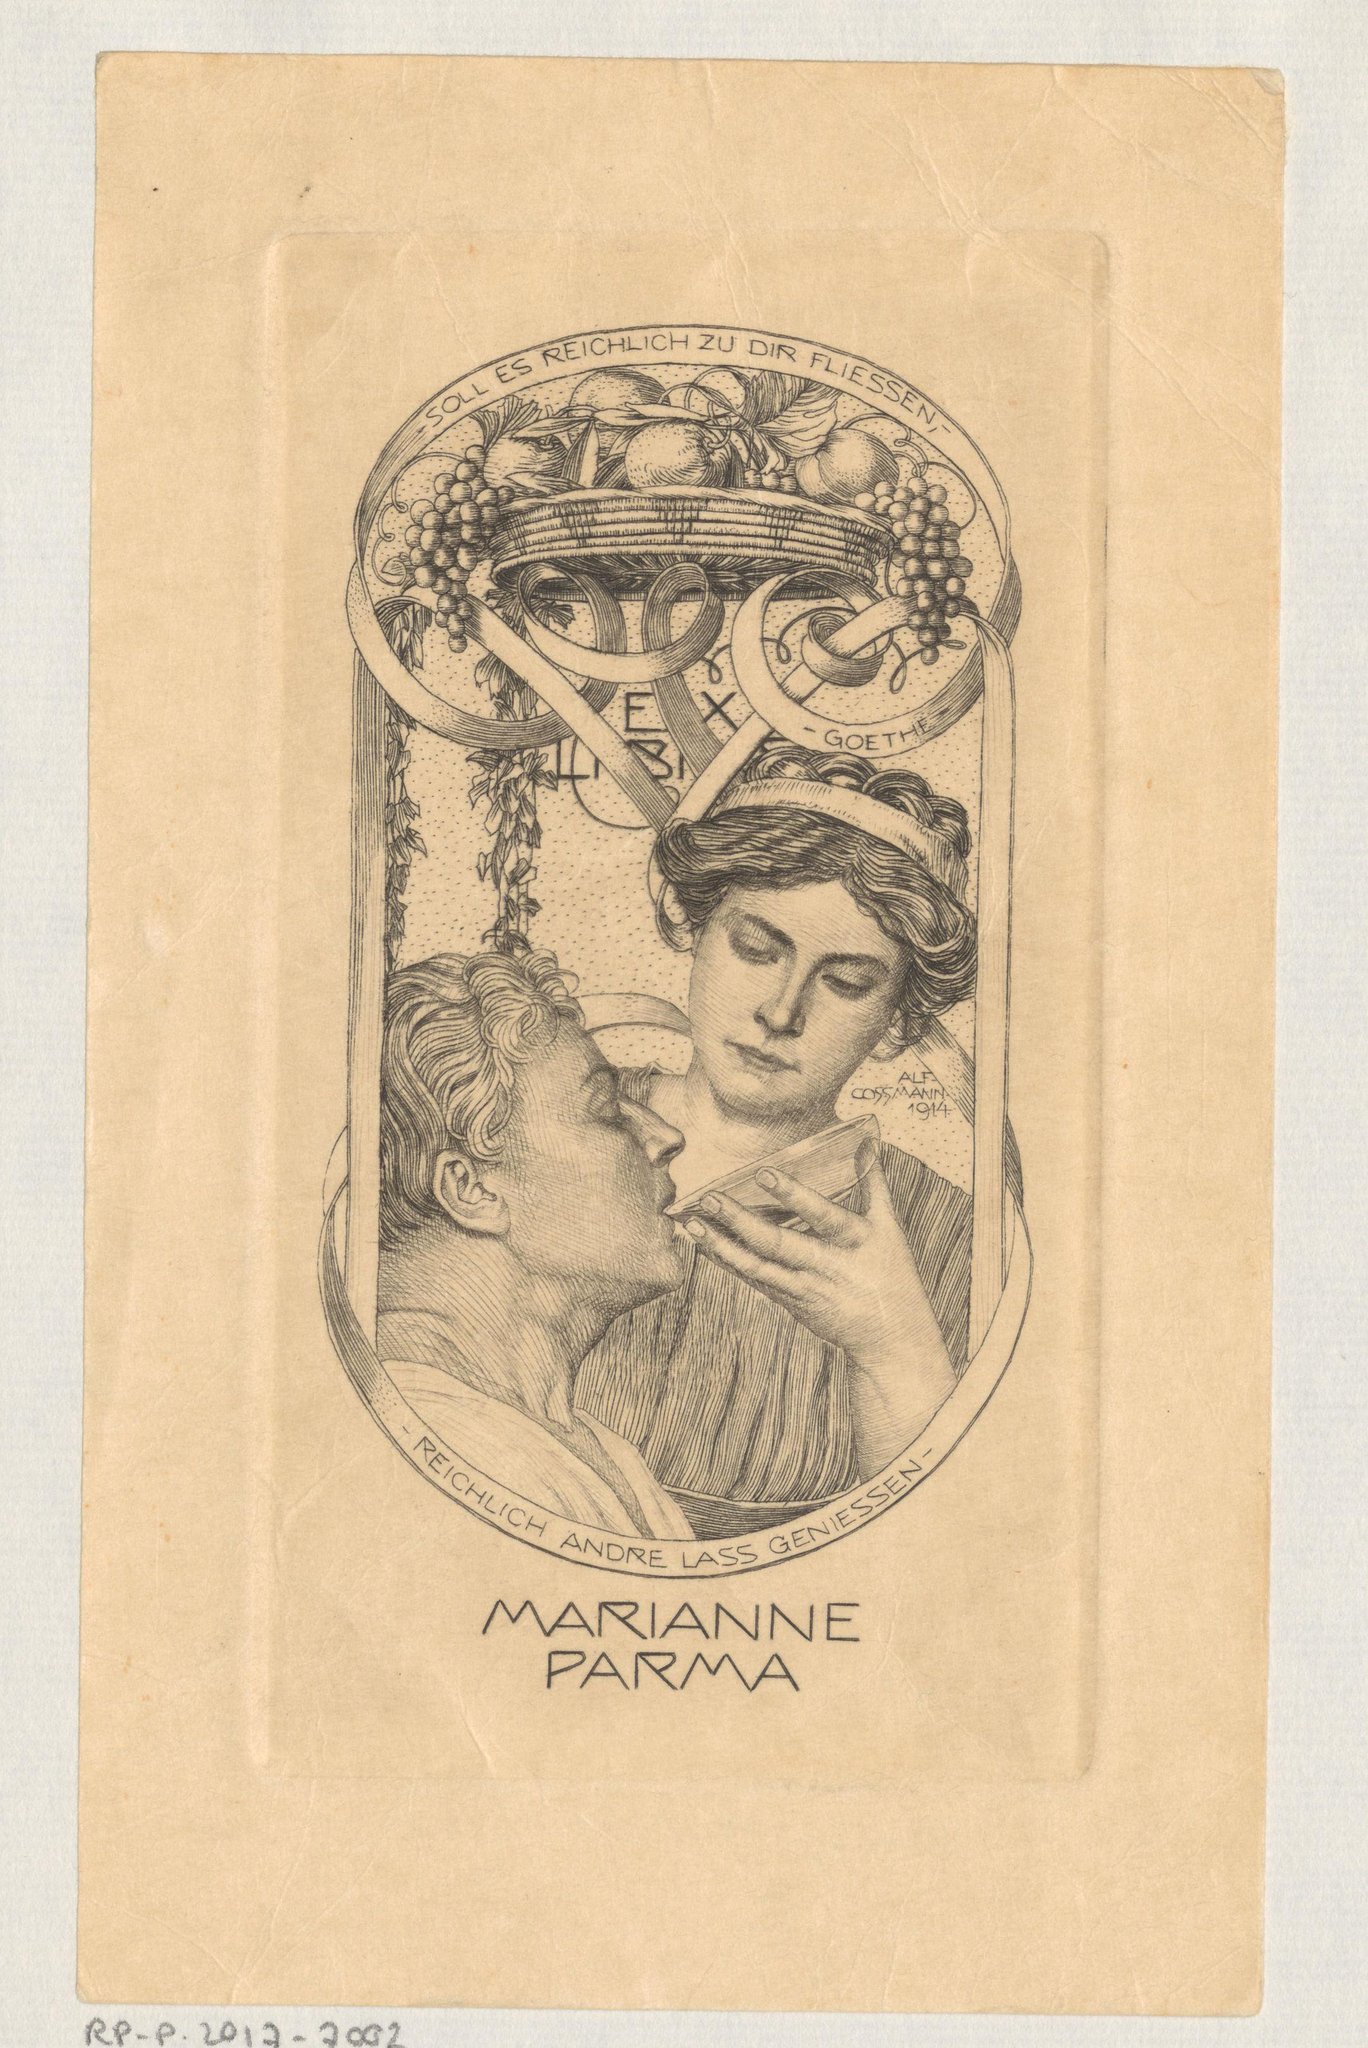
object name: bookplate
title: Ex libris van Marianne Parma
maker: alfred cossmann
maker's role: print maker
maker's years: 1870-1951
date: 1914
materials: paper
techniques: etching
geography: austria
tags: adolescent, young woman, maiden, giving drink, fruits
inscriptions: date